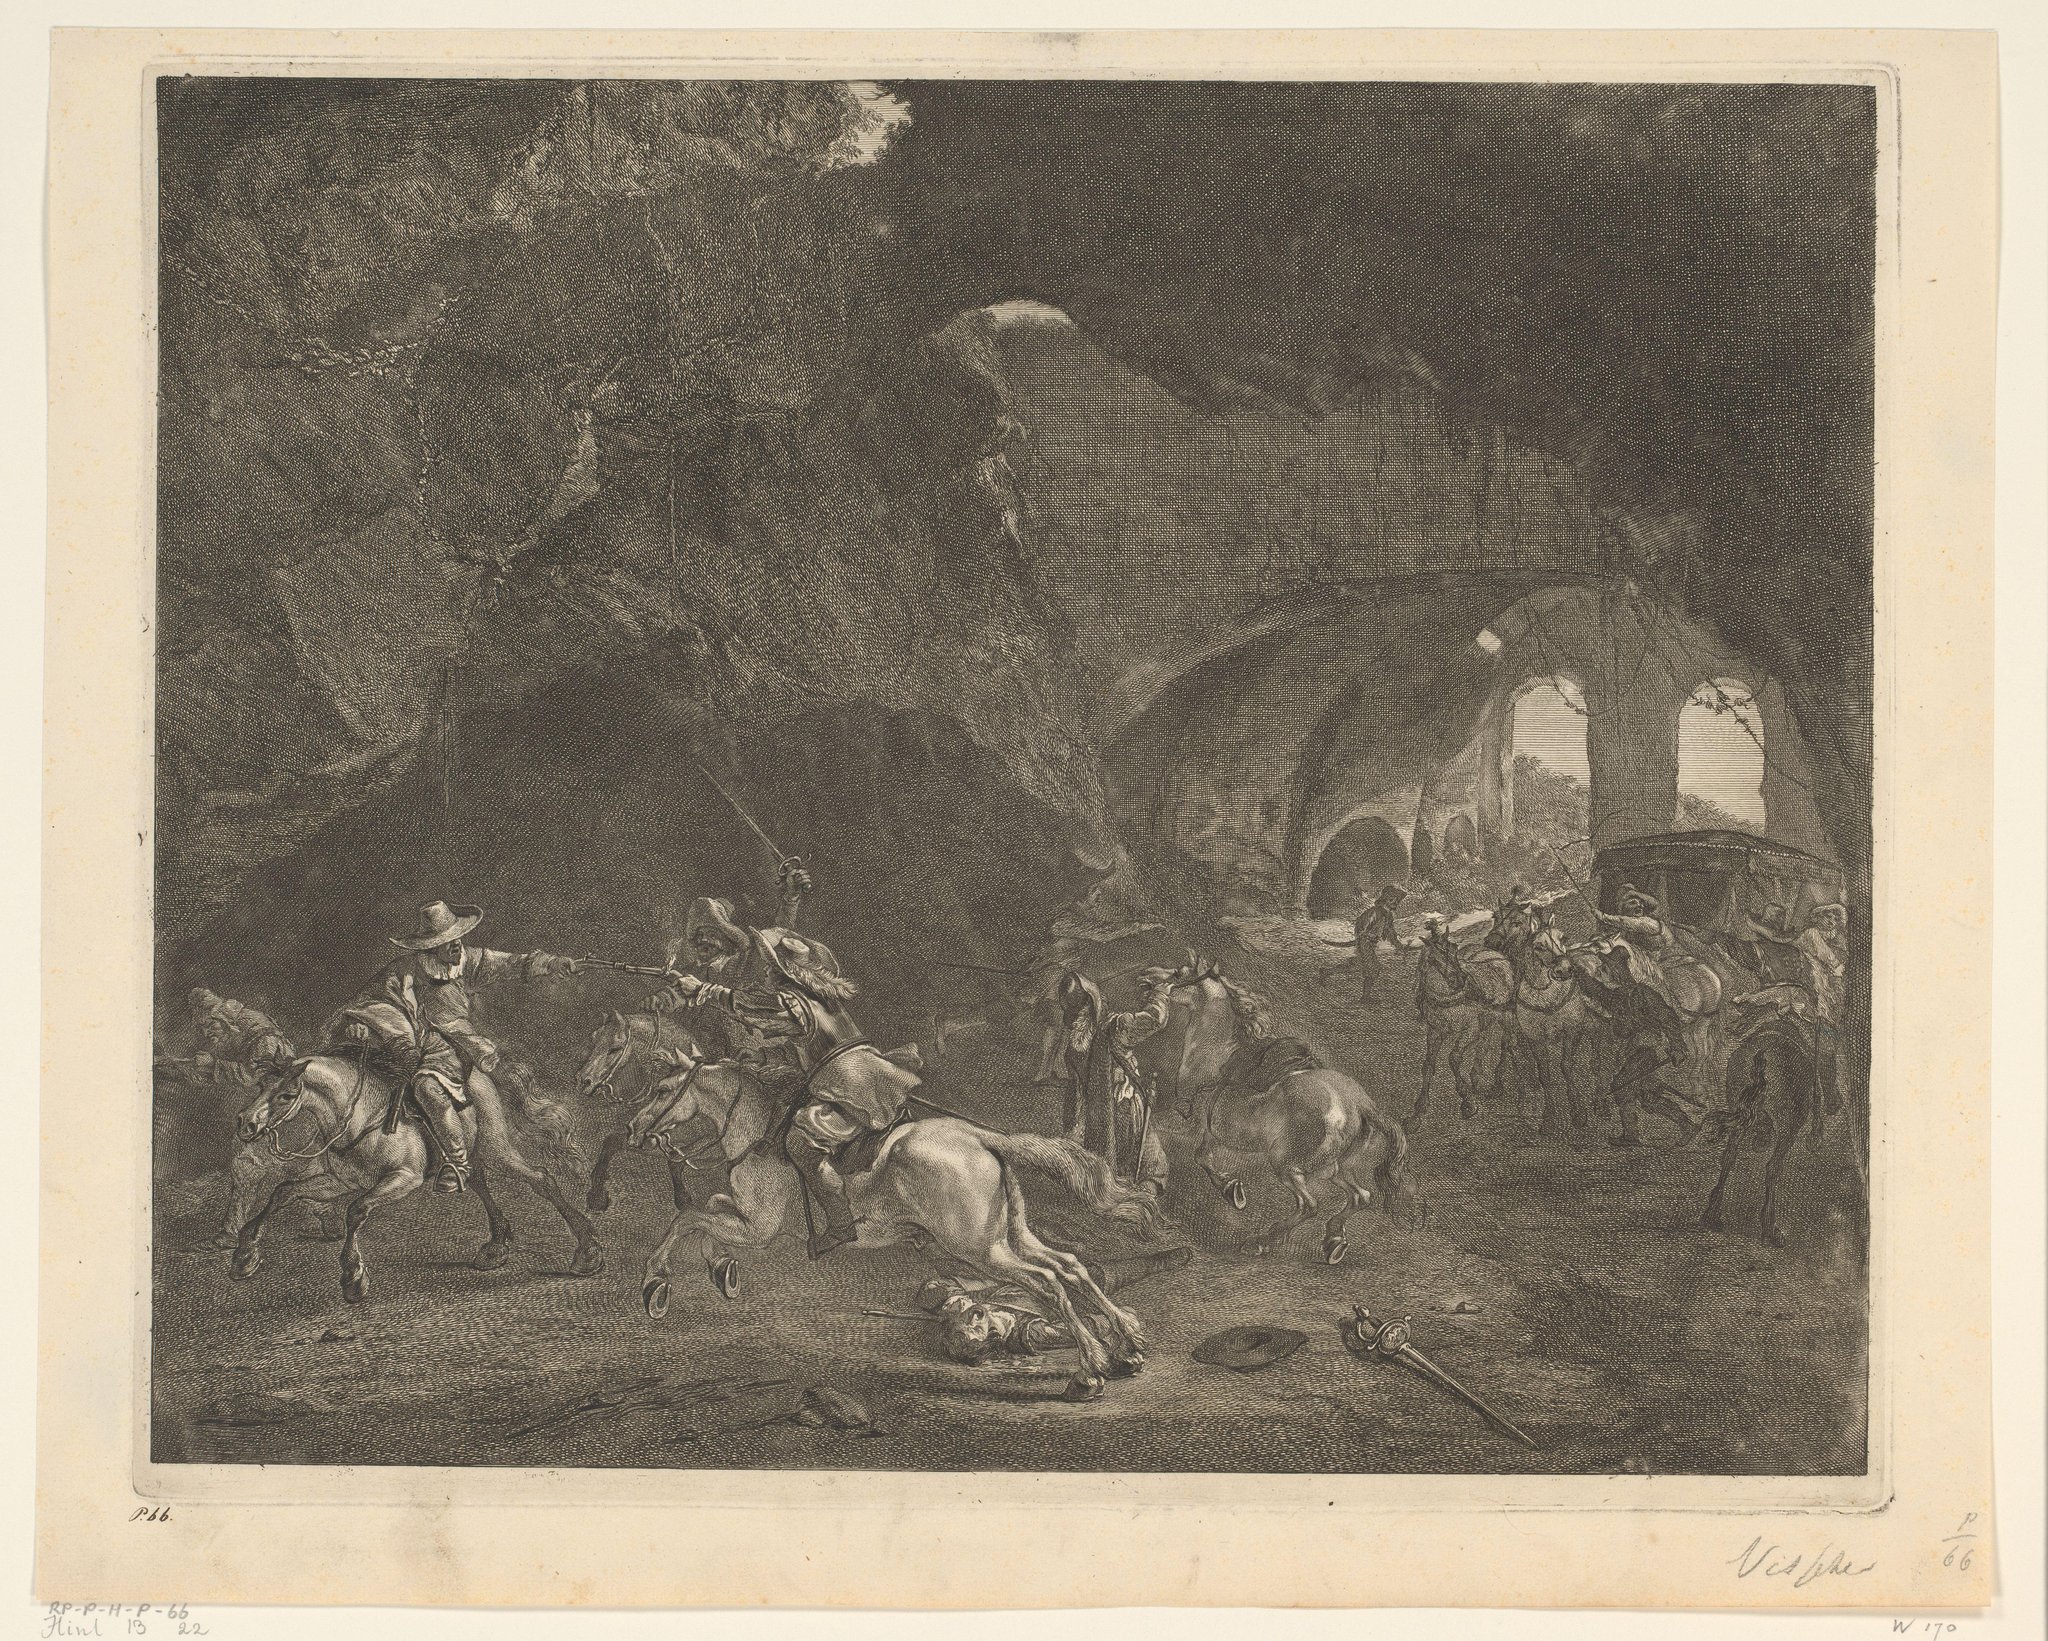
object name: print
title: Caelaturae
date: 1646-1658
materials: paper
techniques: engraving, etching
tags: riding a horse, ass, or mule; rider, horseman, cave, grotto, robbery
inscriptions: collector's mark: Lugt 11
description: Deze prent maakte ten minste tot 1979 deel uit van een prentalbum met de titel: 't Cabinet der Italiaense schilderije antique statue en borstbeelde van de heer Renst 145 stucks. Simon Schijnvoet heeft in 1709 aan dit album het Schijnvoet-nummer 22, liber nummer 20 toegekend. Prent uit serie Caelaturae met vierendertig reprodukties naar Italiaanse en Nederlandse schilders, vervaardigd door de allerbeste graveurs in opdracht van de verzamelaar Gerard Reynst.